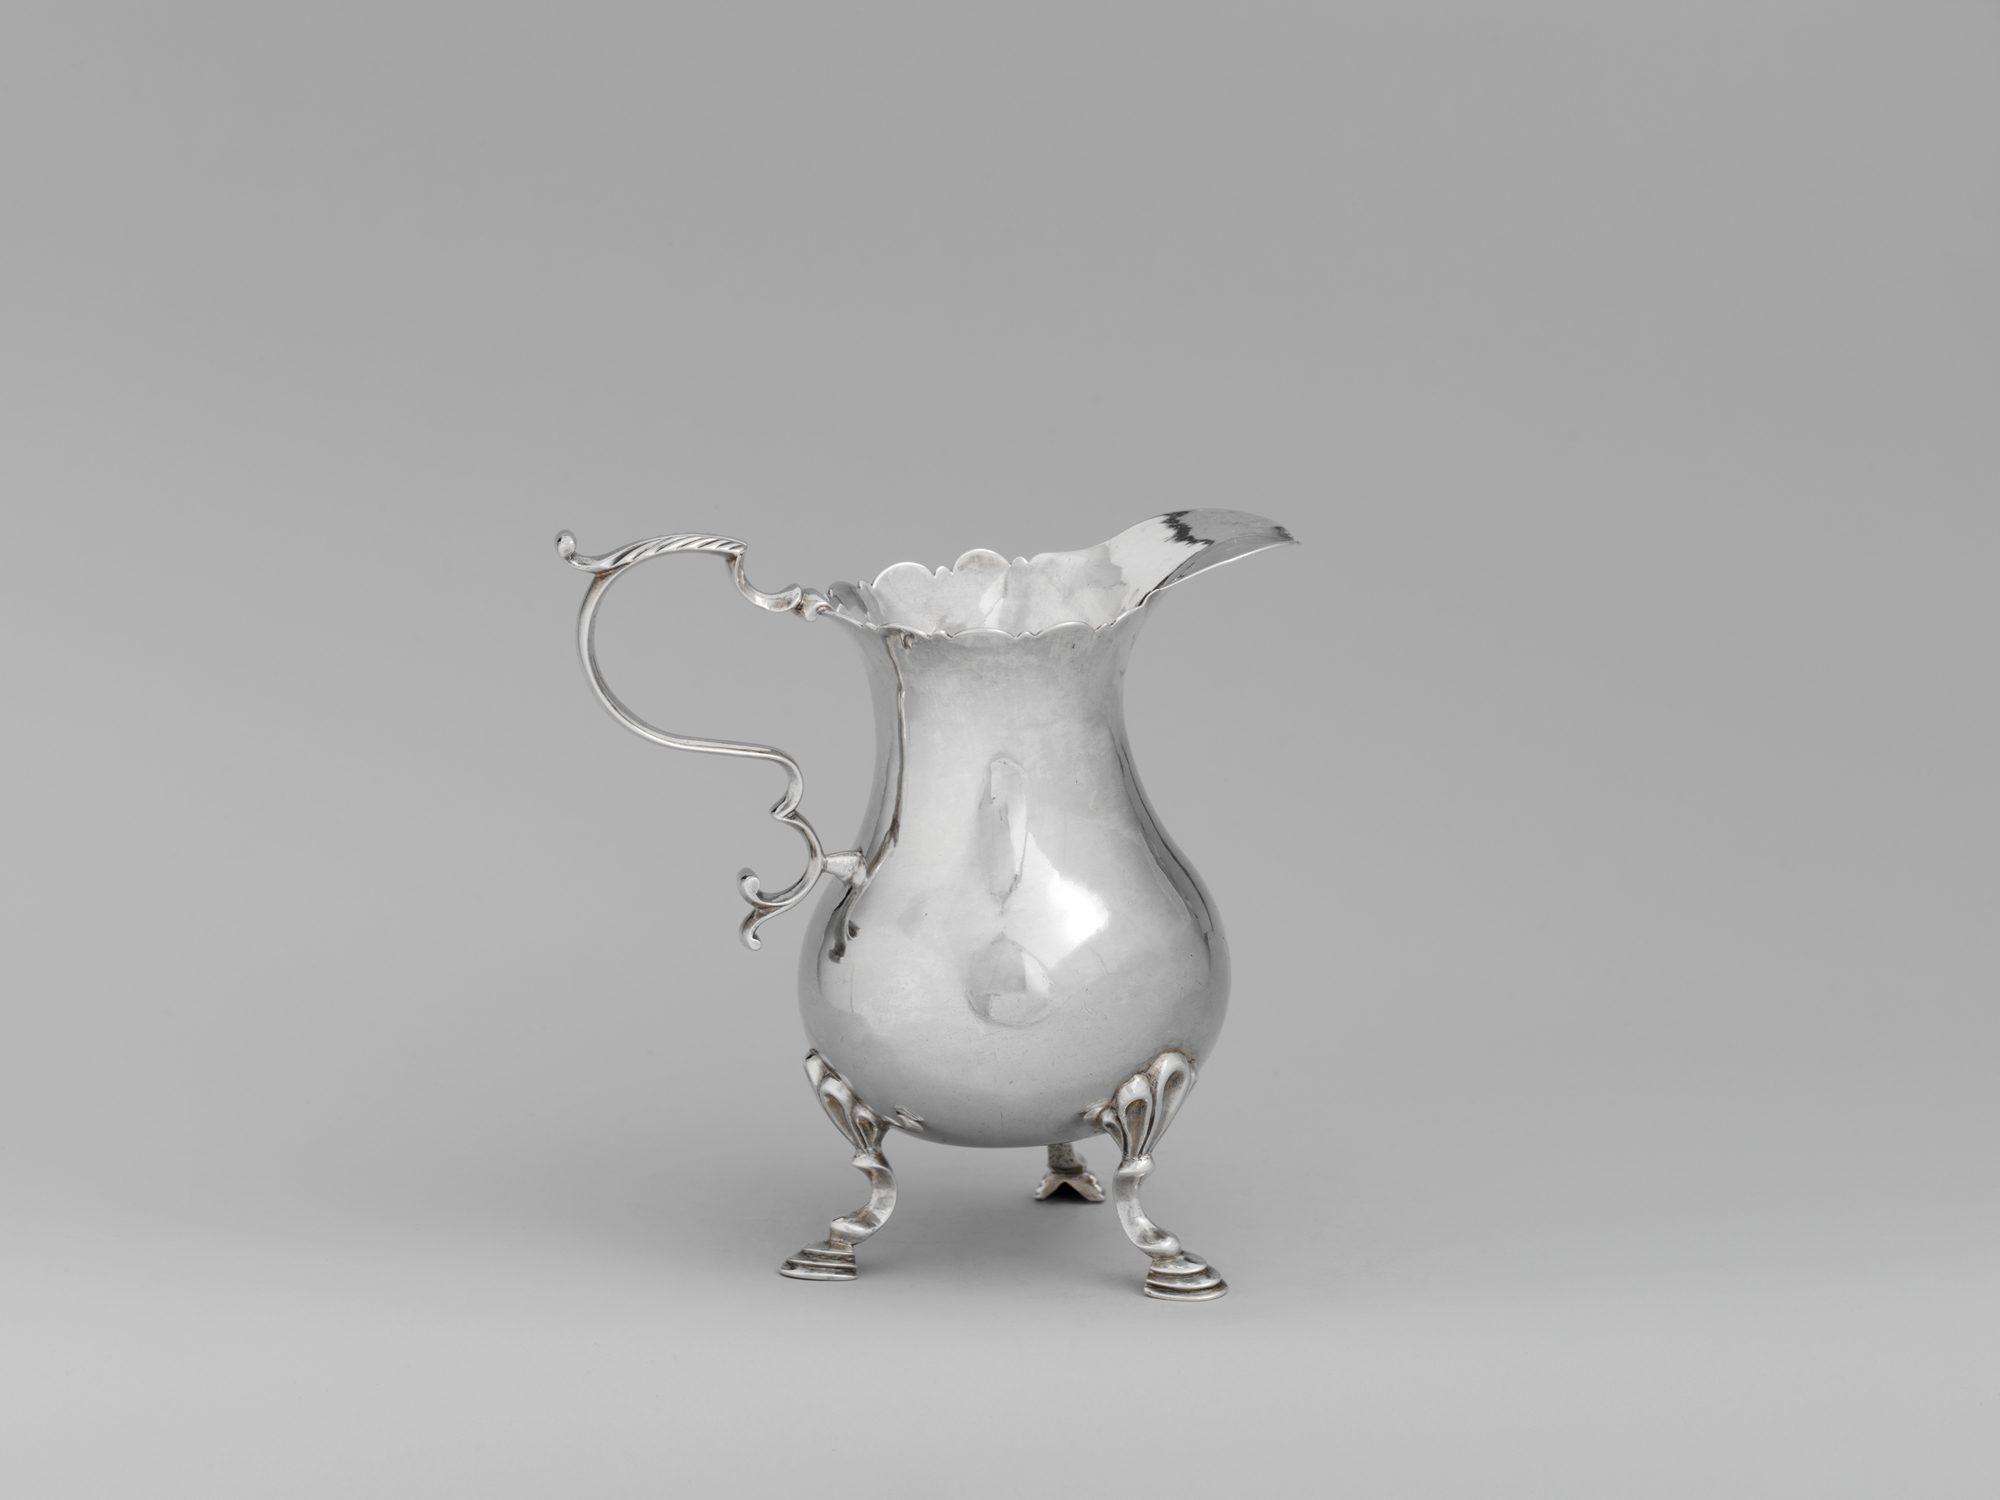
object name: cream pot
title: Creamer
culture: american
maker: thomas arnold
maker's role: maker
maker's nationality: american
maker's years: 1739-1828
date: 1760-1775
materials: silver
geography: united states